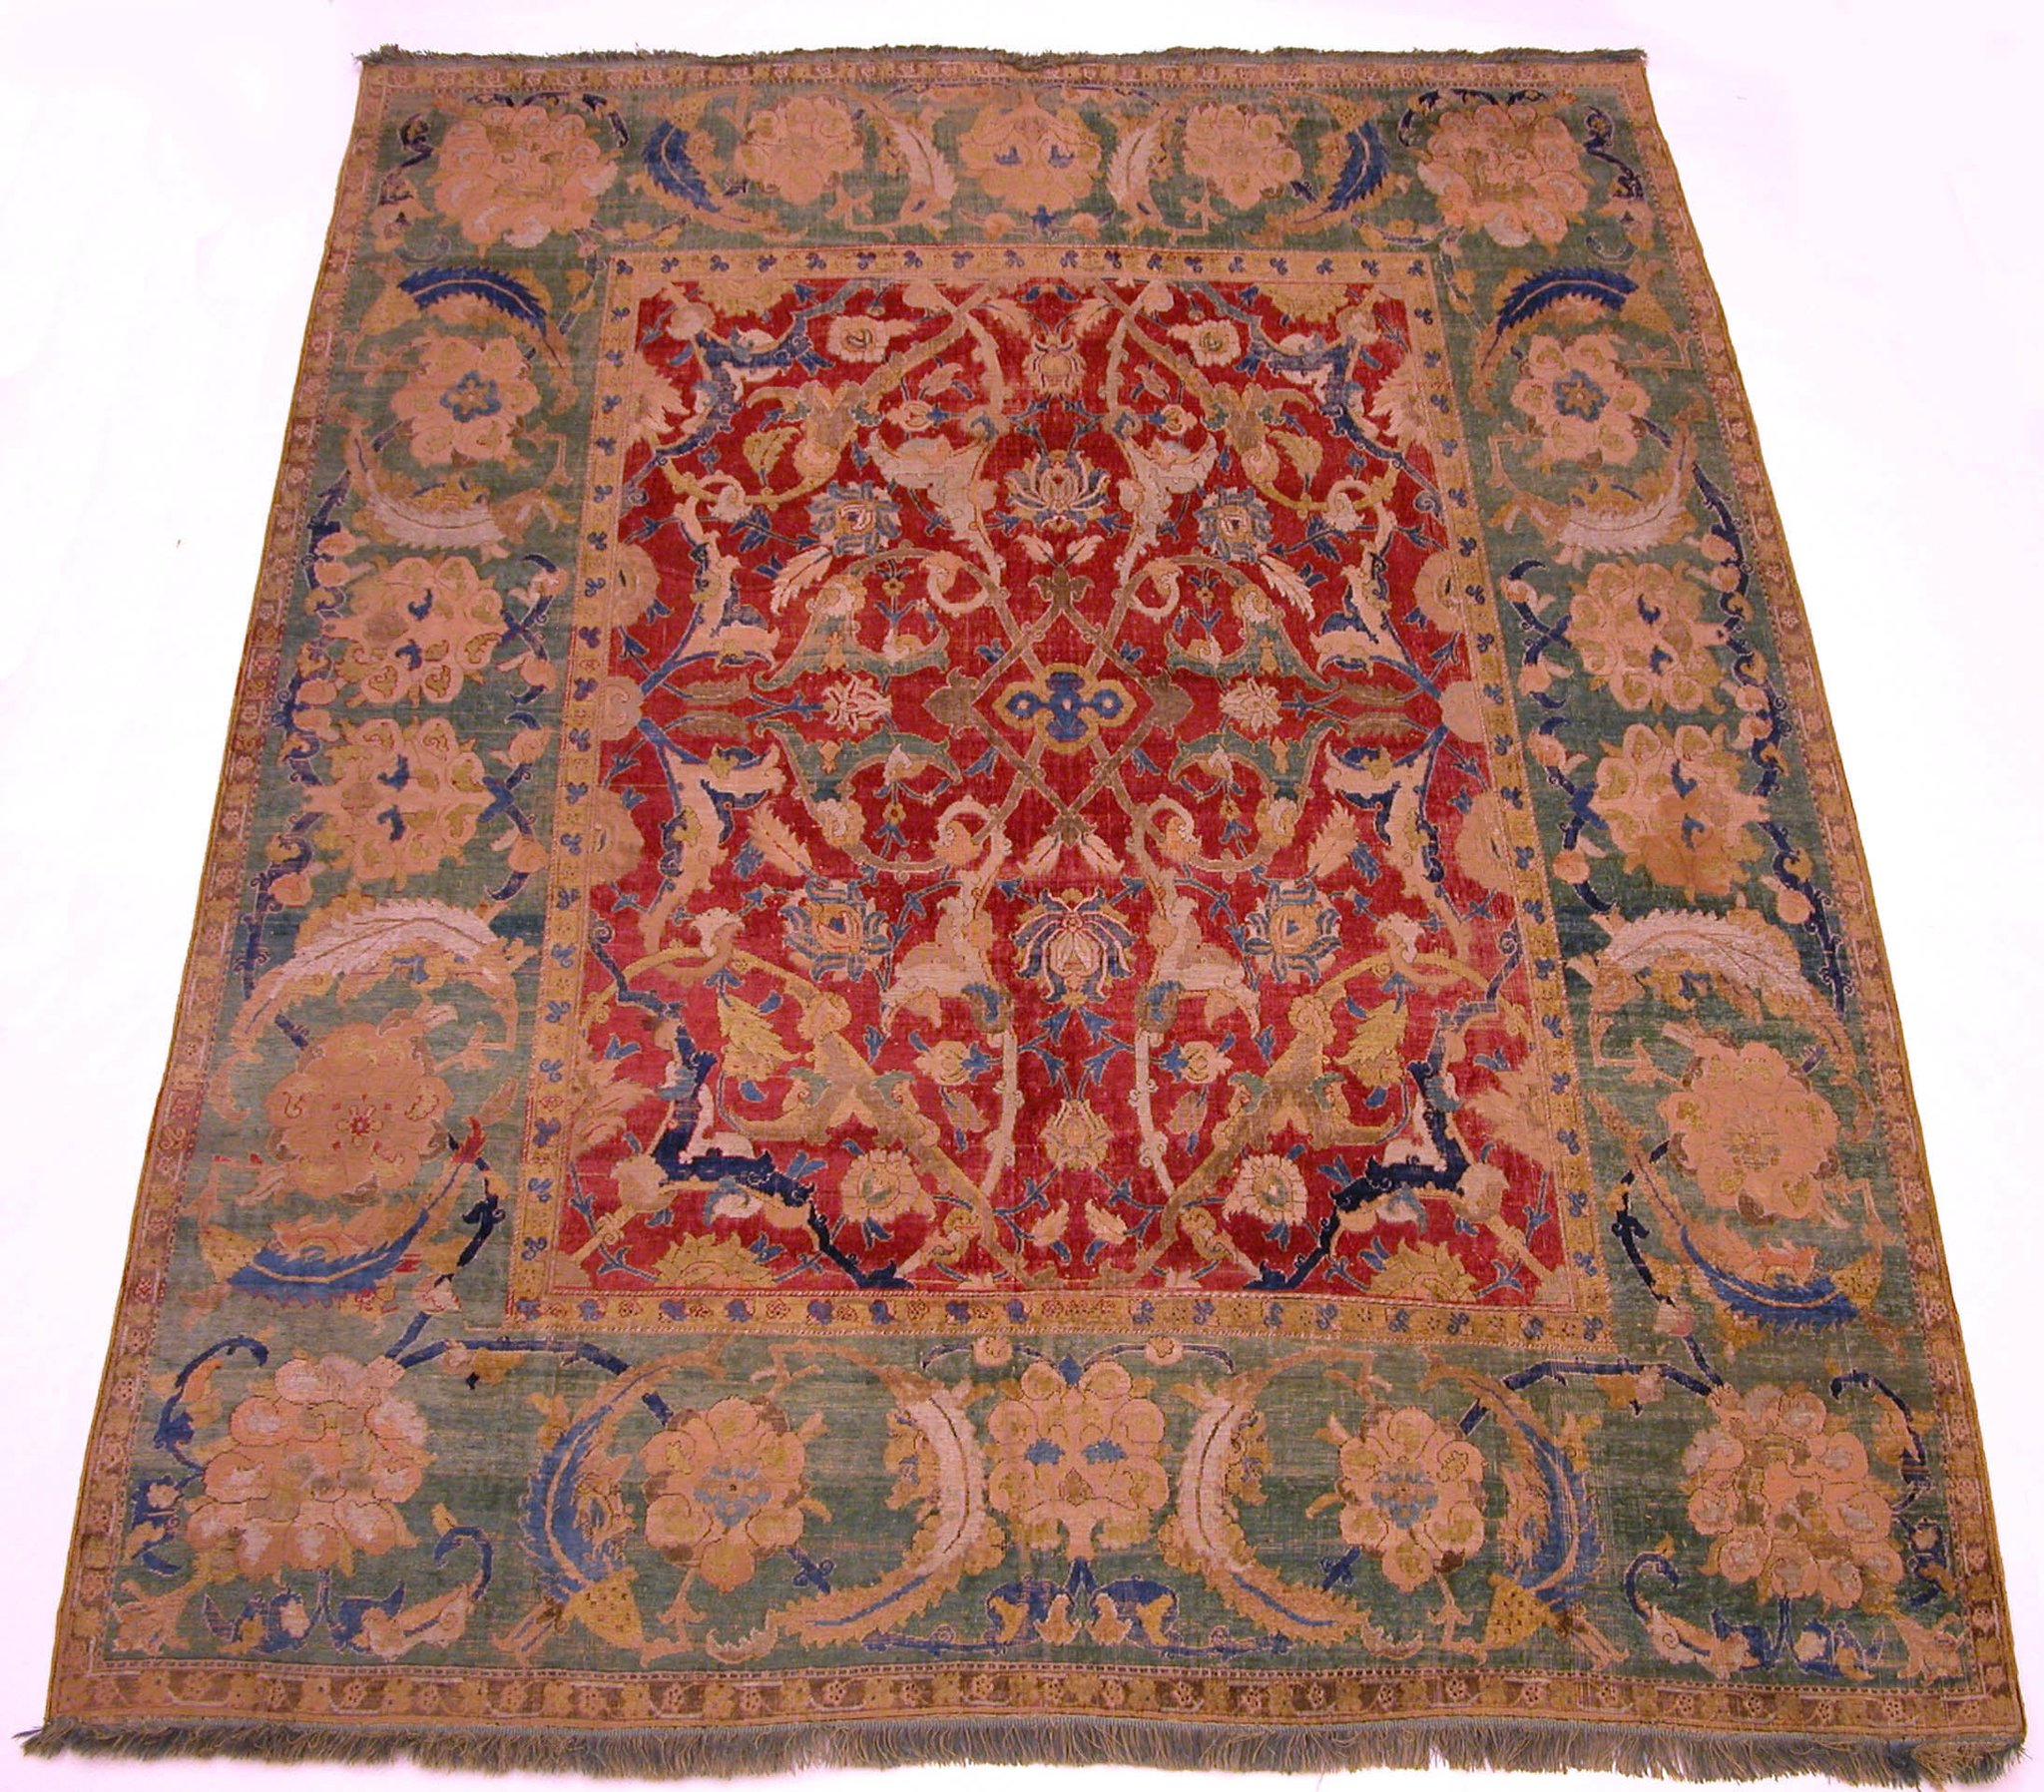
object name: carpet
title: Polonaise Carpet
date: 1601-1700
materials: silk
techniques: asymmetrically knotted pile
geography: iran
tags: flowers